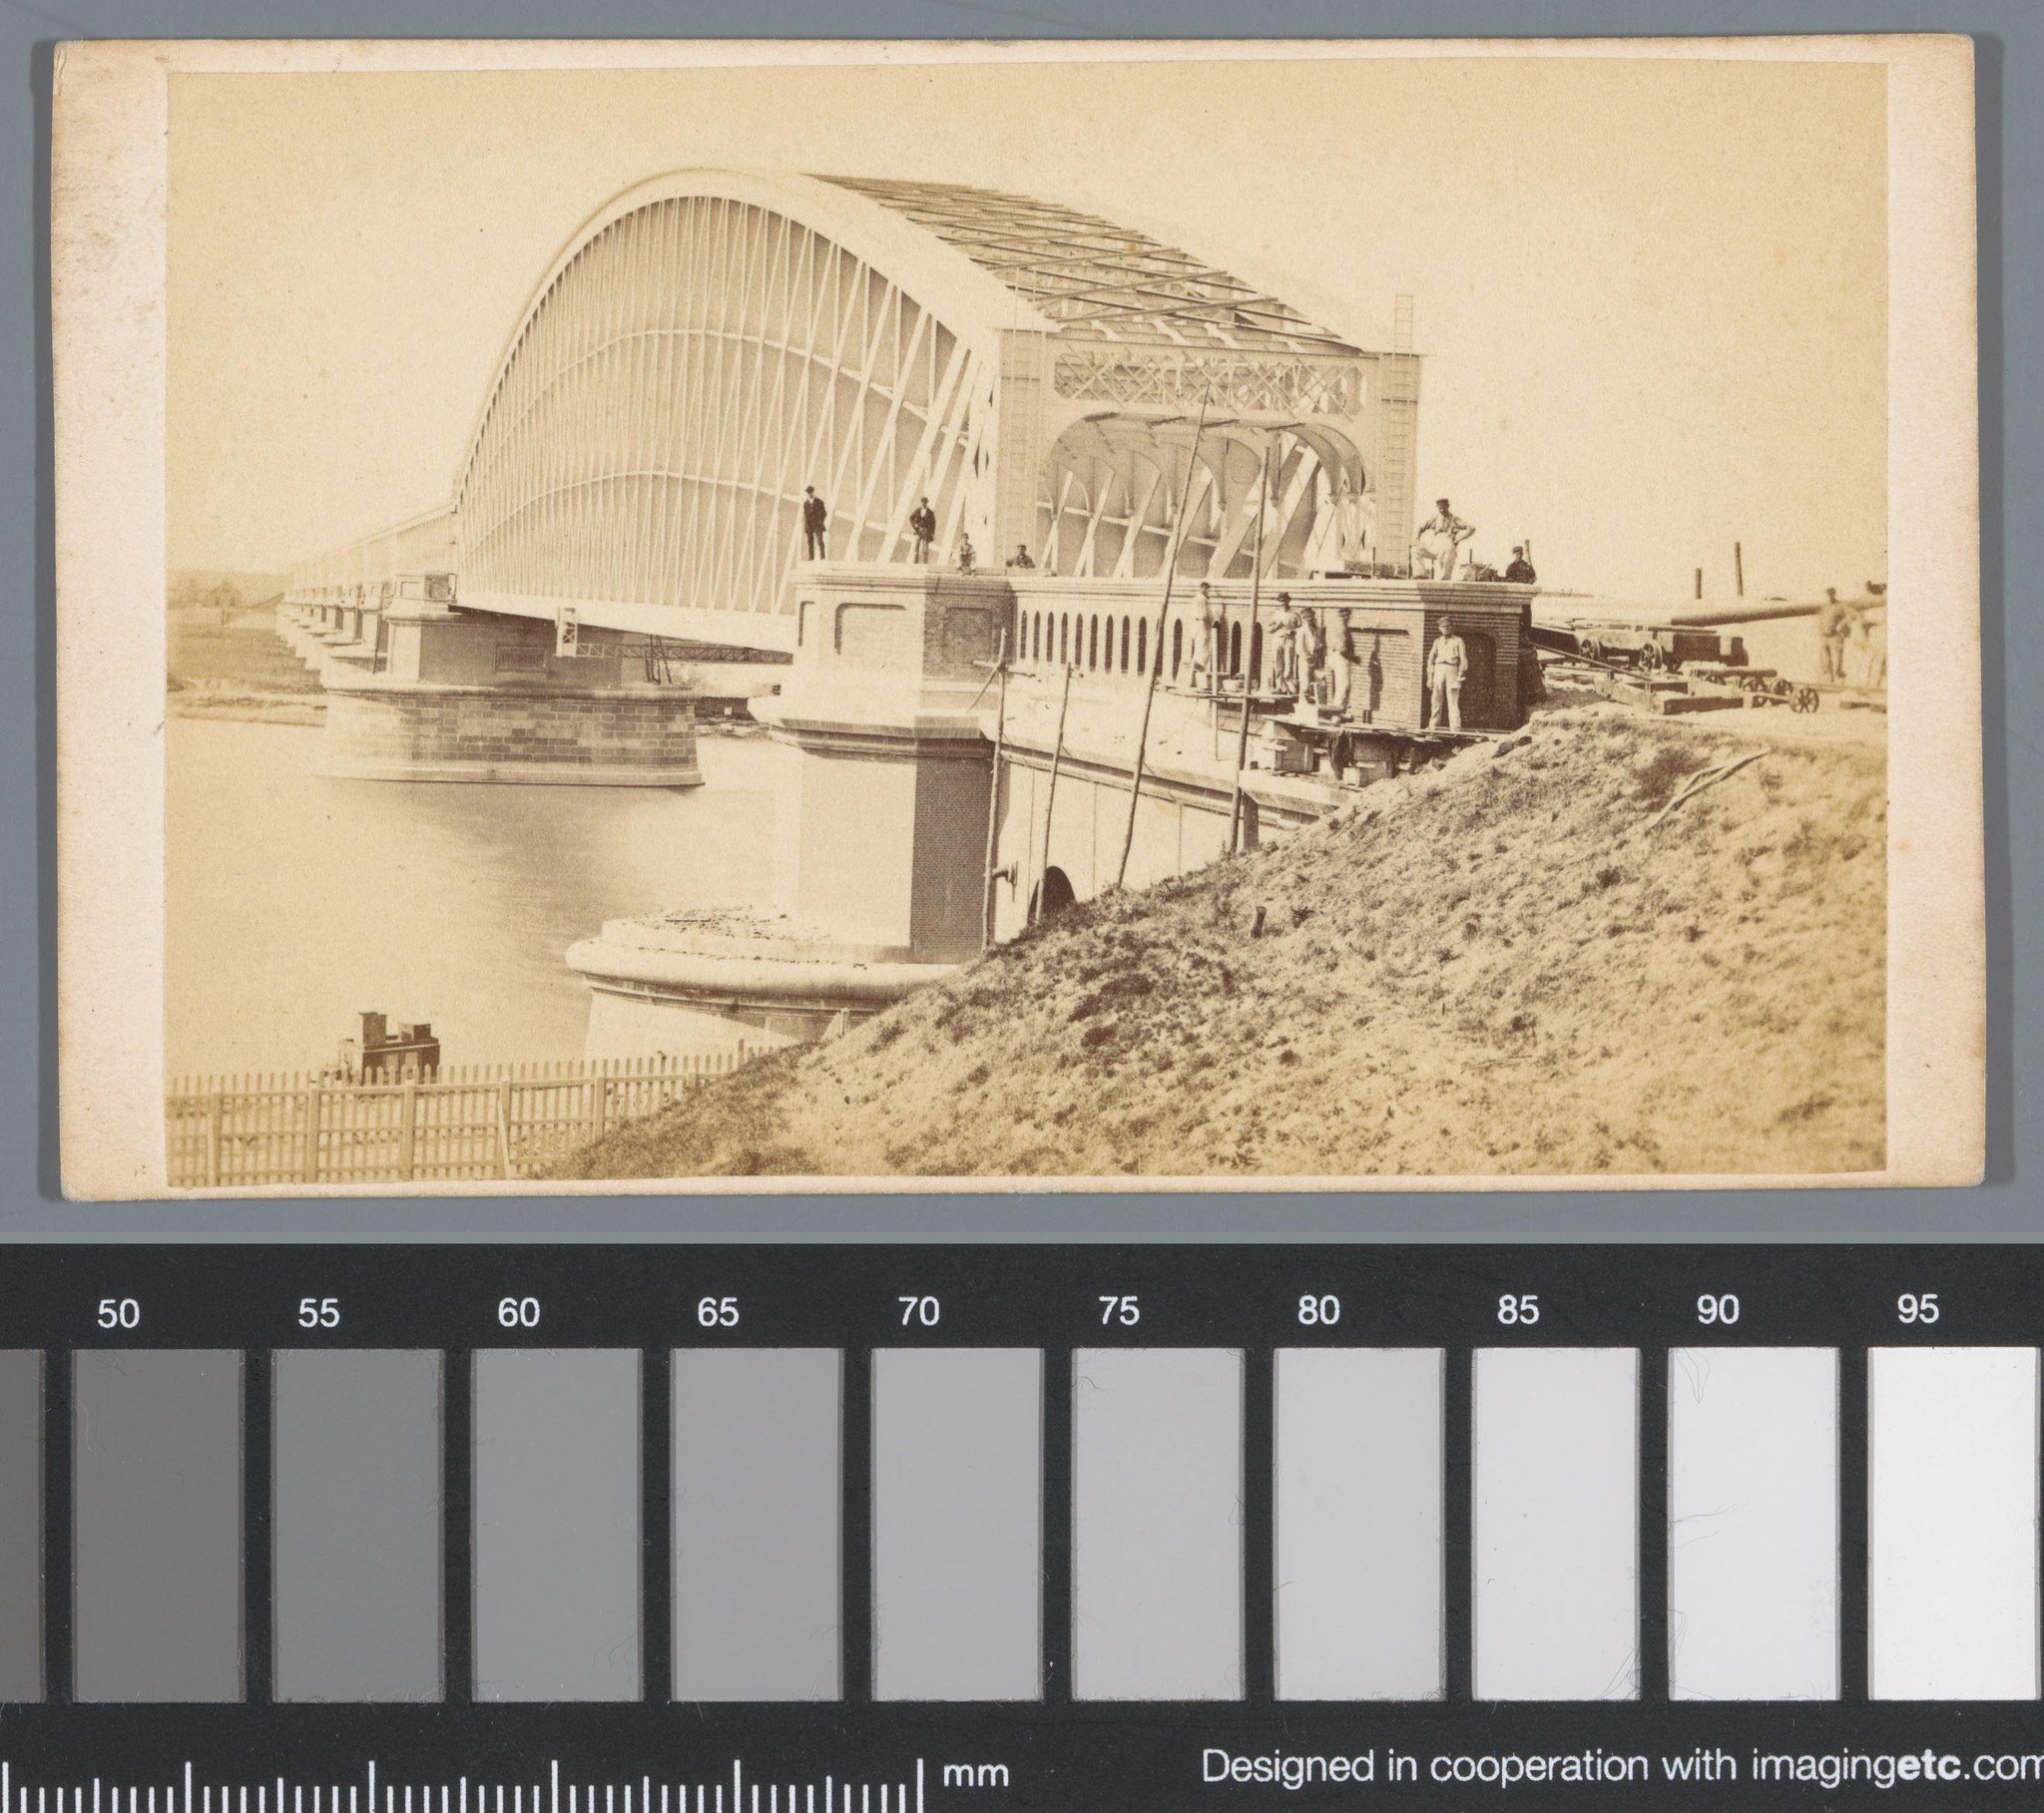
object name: carte de visite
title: Spoorbrug in aanbouw, mogelijk in Nederland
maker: pieter oosterhuis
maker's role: draughtsman, print maker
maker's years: 1816-1885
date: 1868-1885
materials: cardboard, paper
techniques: albumen print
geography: culemborg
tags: bridge in village across river, canal, etc. - ii - ideal landscapes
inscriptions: number: ‘176’